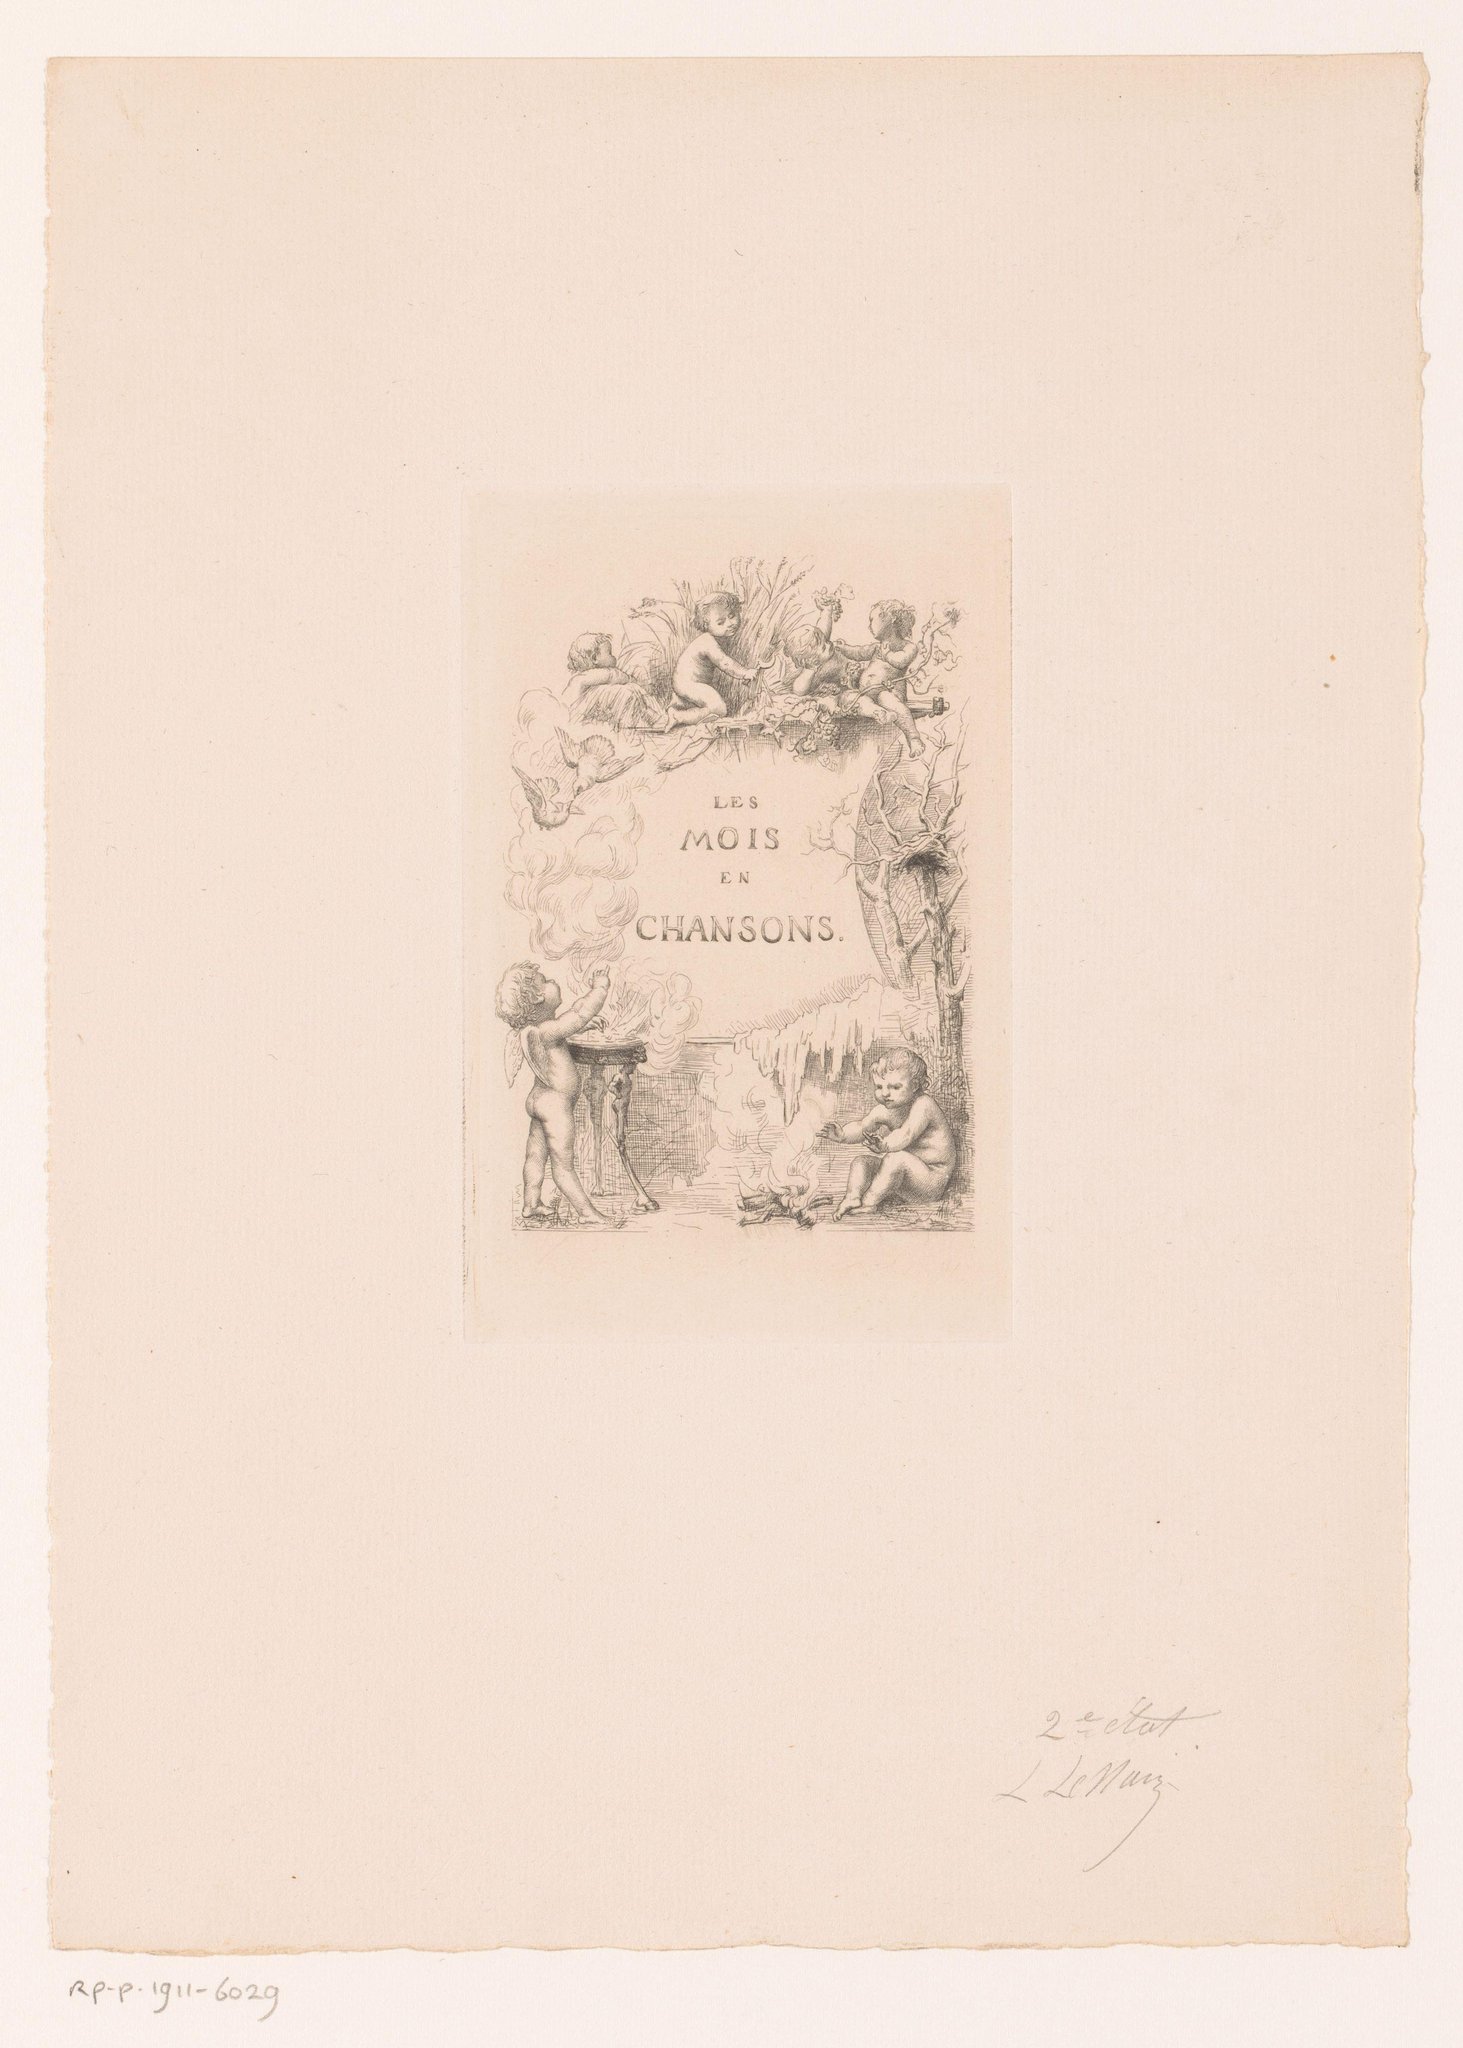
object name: titelblad, titelpagina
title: Titelpagina voor: Les Mois en Chansons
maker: louis le nain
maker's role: print maker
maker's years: 1851-1939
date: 1861-1911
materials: paper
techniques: etching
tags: seasons of the year represented by scenes showing human activities, usually in a landscape, cupids: 'amores', 'amoretti', 'putti'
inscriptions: collector's mark: Lugt 2228, inscription: ‘2e état LLe Nain’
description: De putti verbeelden verschillende maanden uit het jaar en de bijhorende activiteiten, onder andere het oogsten van graan en wijn.